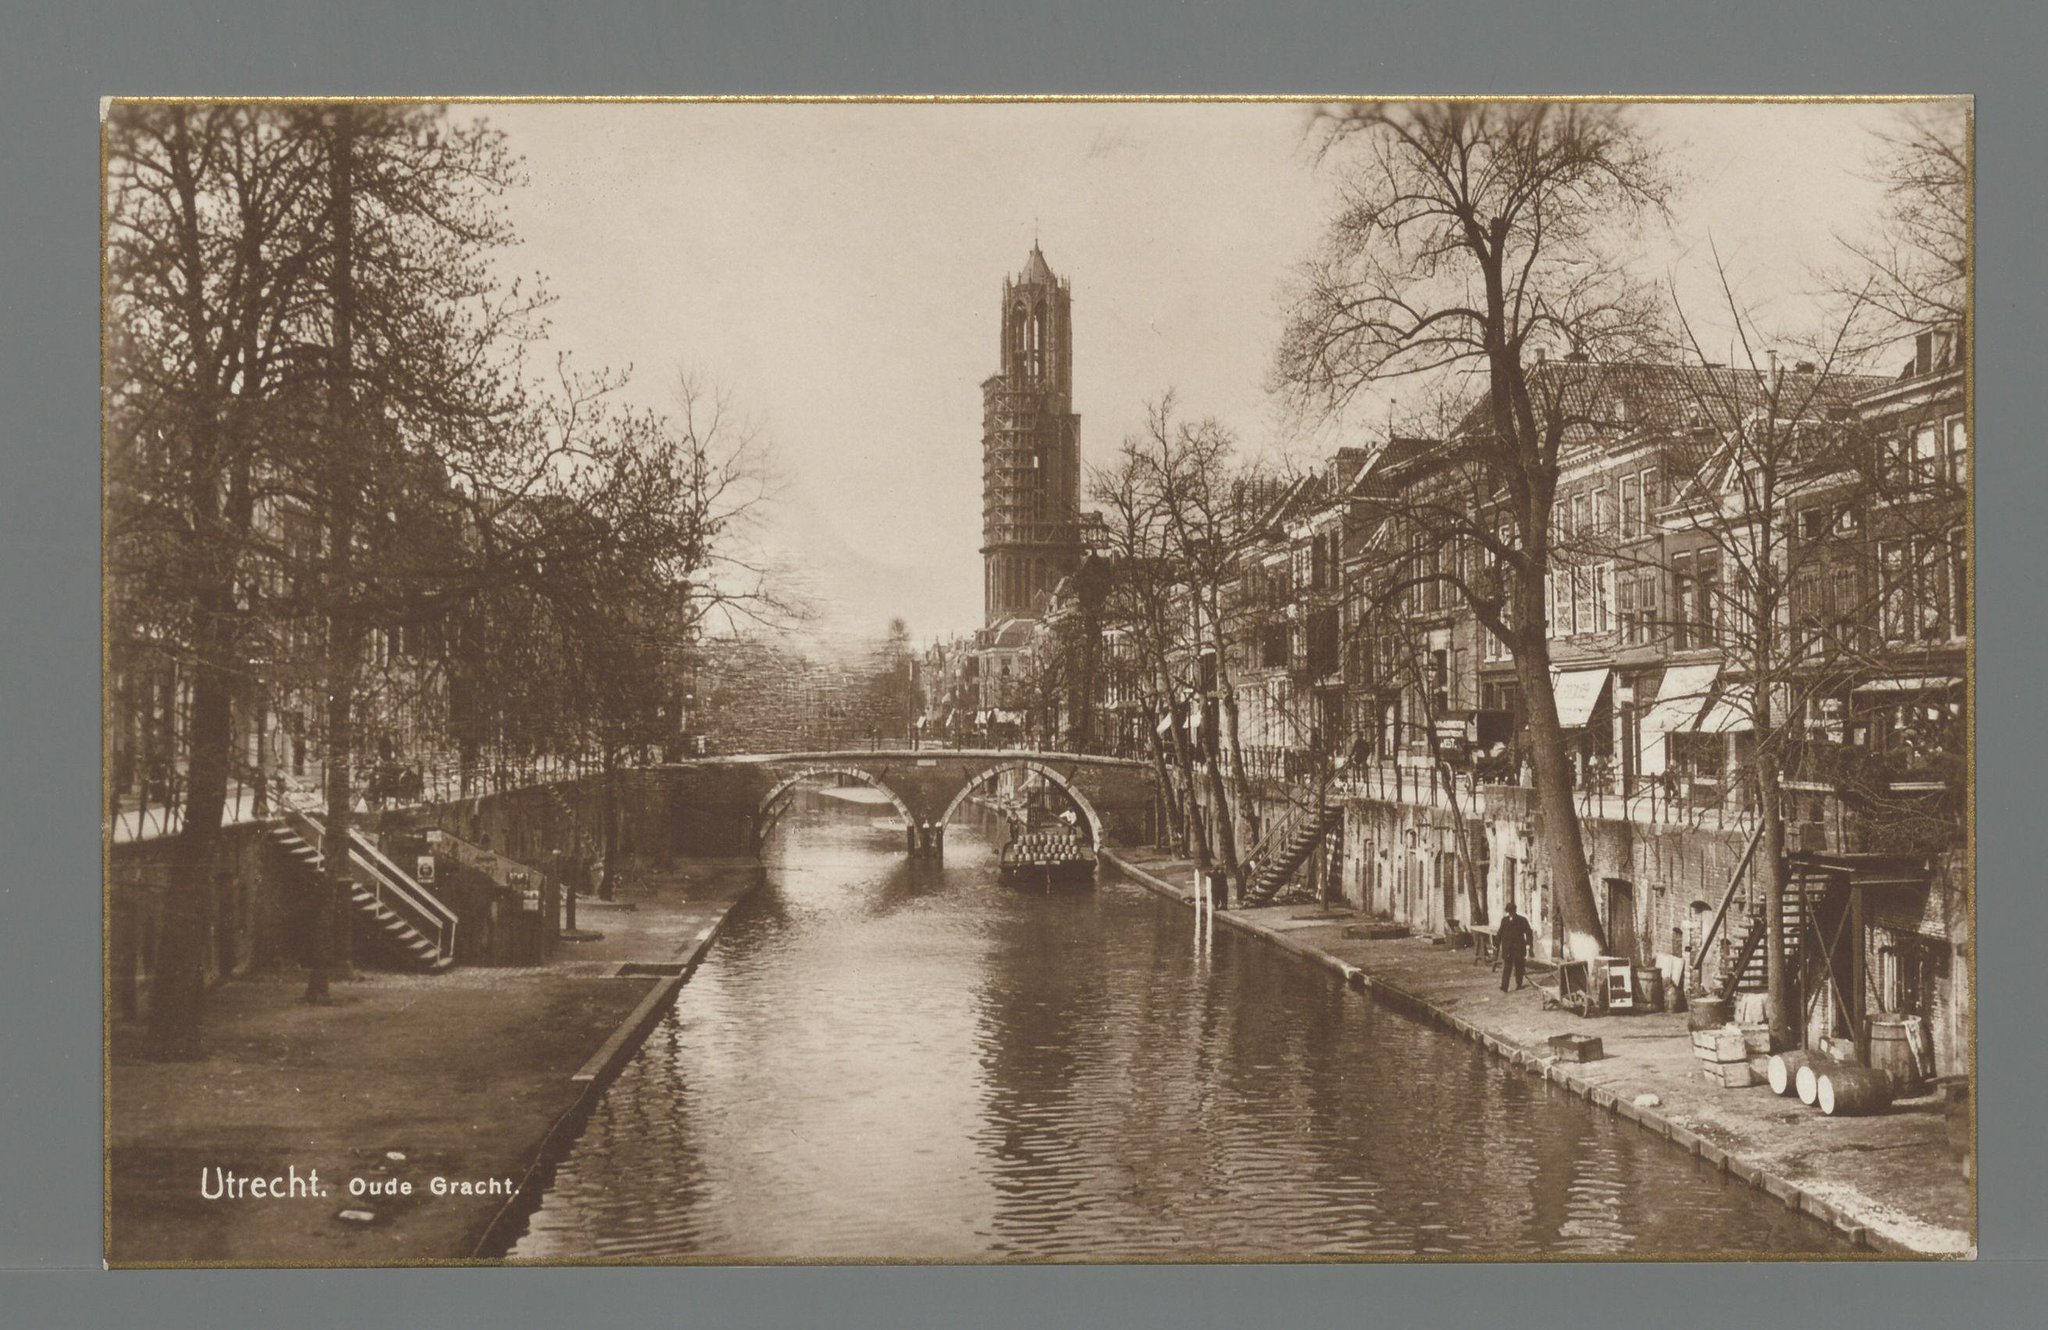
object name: photograph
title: Utrecht. Oude gracht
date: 1905-1926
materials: paper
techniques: gelatin silver print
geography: amsterdam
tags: scaffold (~ building activities), church (exterior), canals, waters (in city), bridge in city across river, canal, etc., street